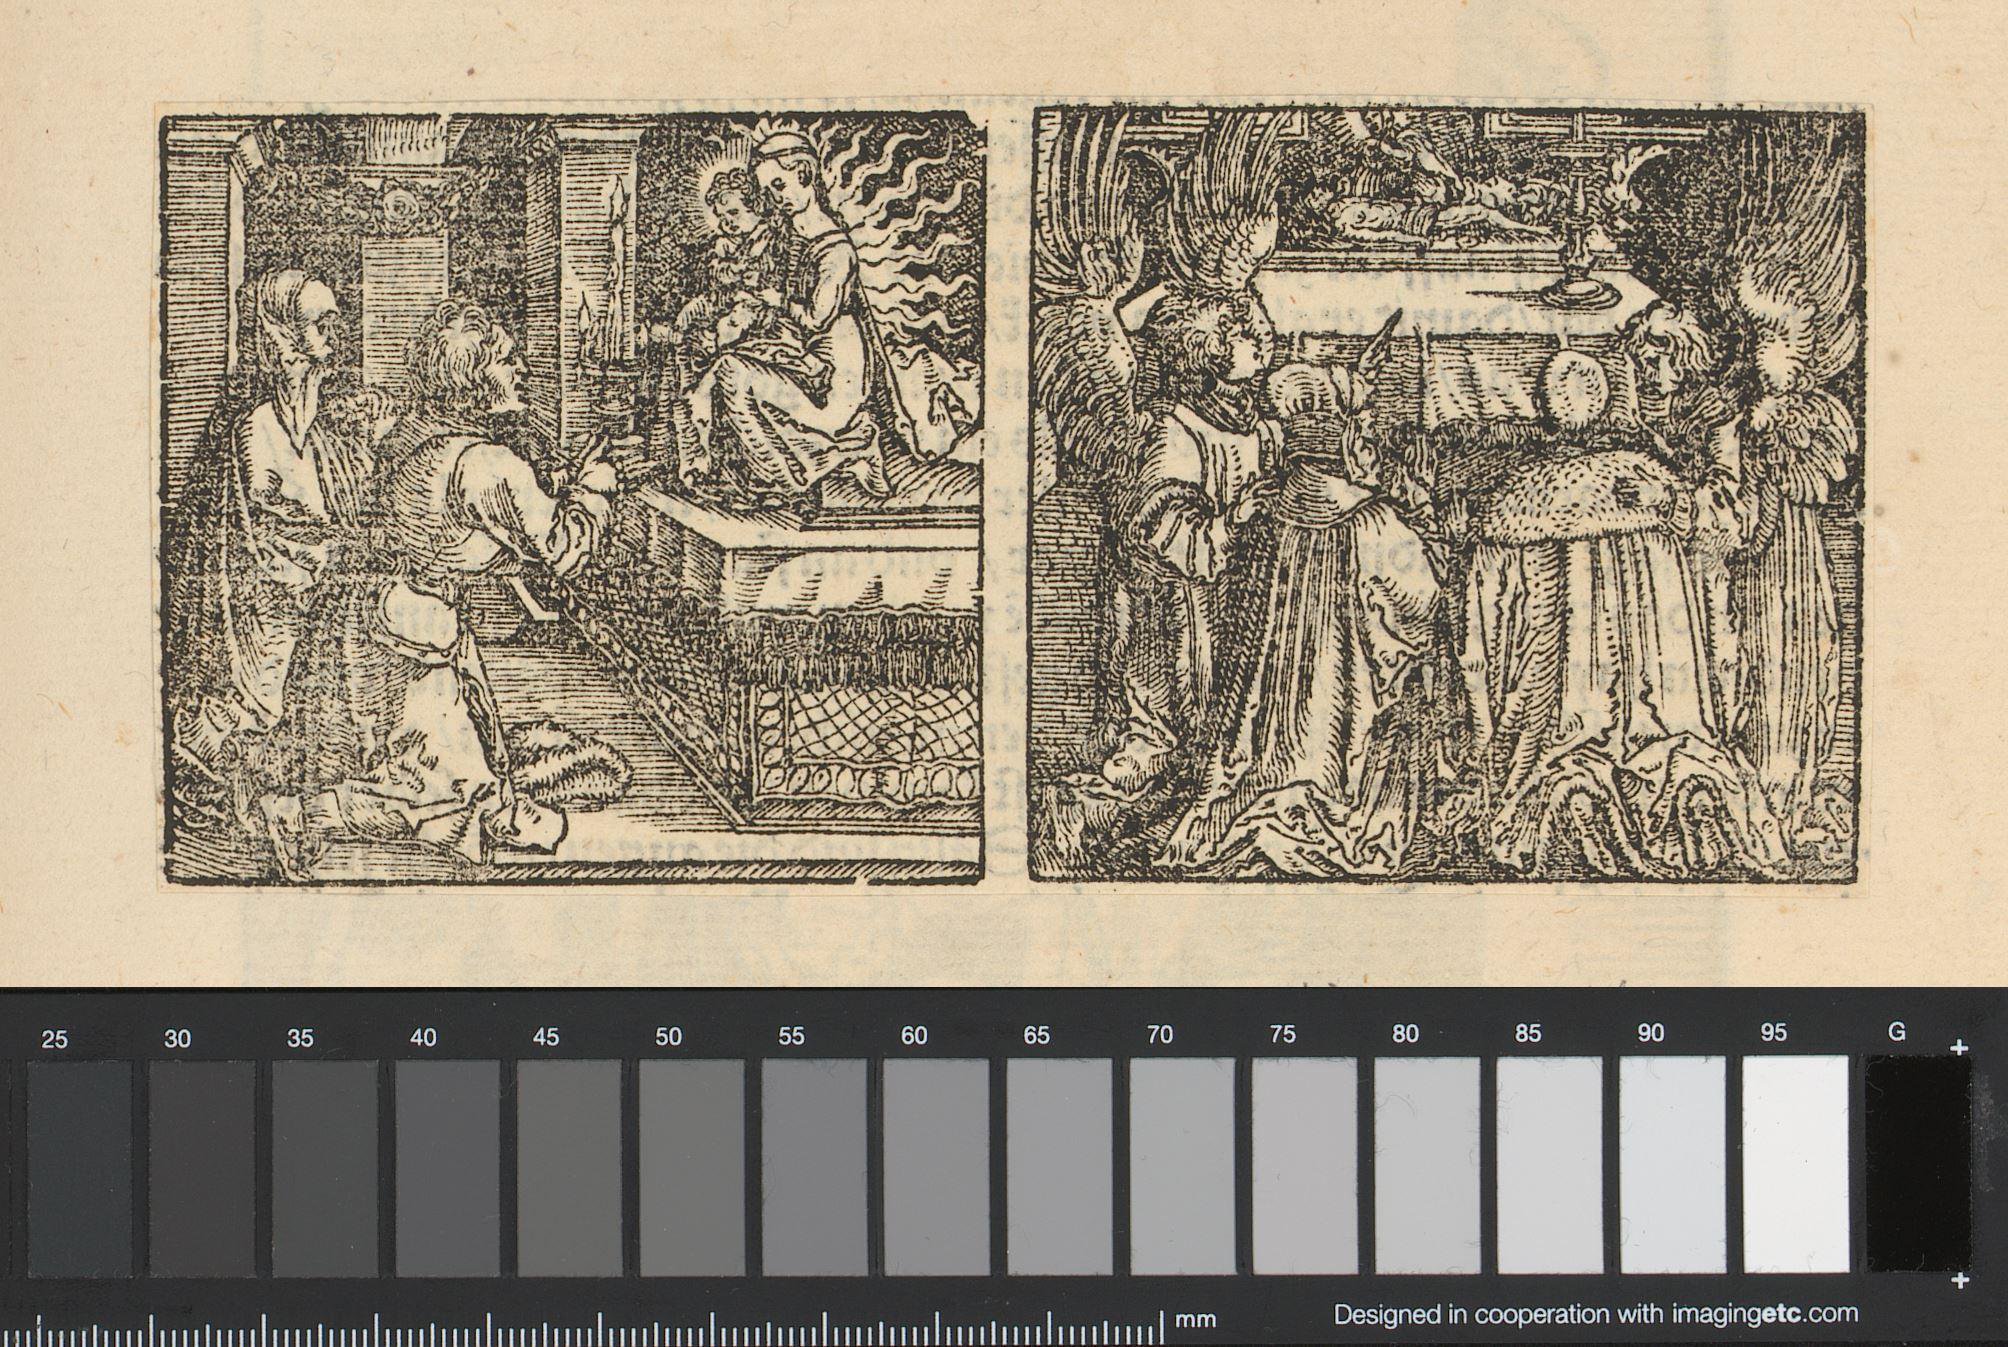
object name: album leaf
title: Twee biddende mensen voor een Mariabeeld en een voorstelling van knielende mensen, begeleid door engelen, voor een altaar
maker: Anonymous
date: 1514-1532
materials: paper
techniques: letterpress printing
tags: (public) prayer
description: Deze prent is gebruikt in: Petrarca, Francesco. Von der Artzney bayder Glück, des guten und widerwertigen: unnd weß sich ain yeder inn Gelück und Unglück halten sol (...). Augsburg: Heinrich Steiner, 1532. Deze uitgave is ook bekend onder de titel 'Trostspiegel in Glück und Unglück'.